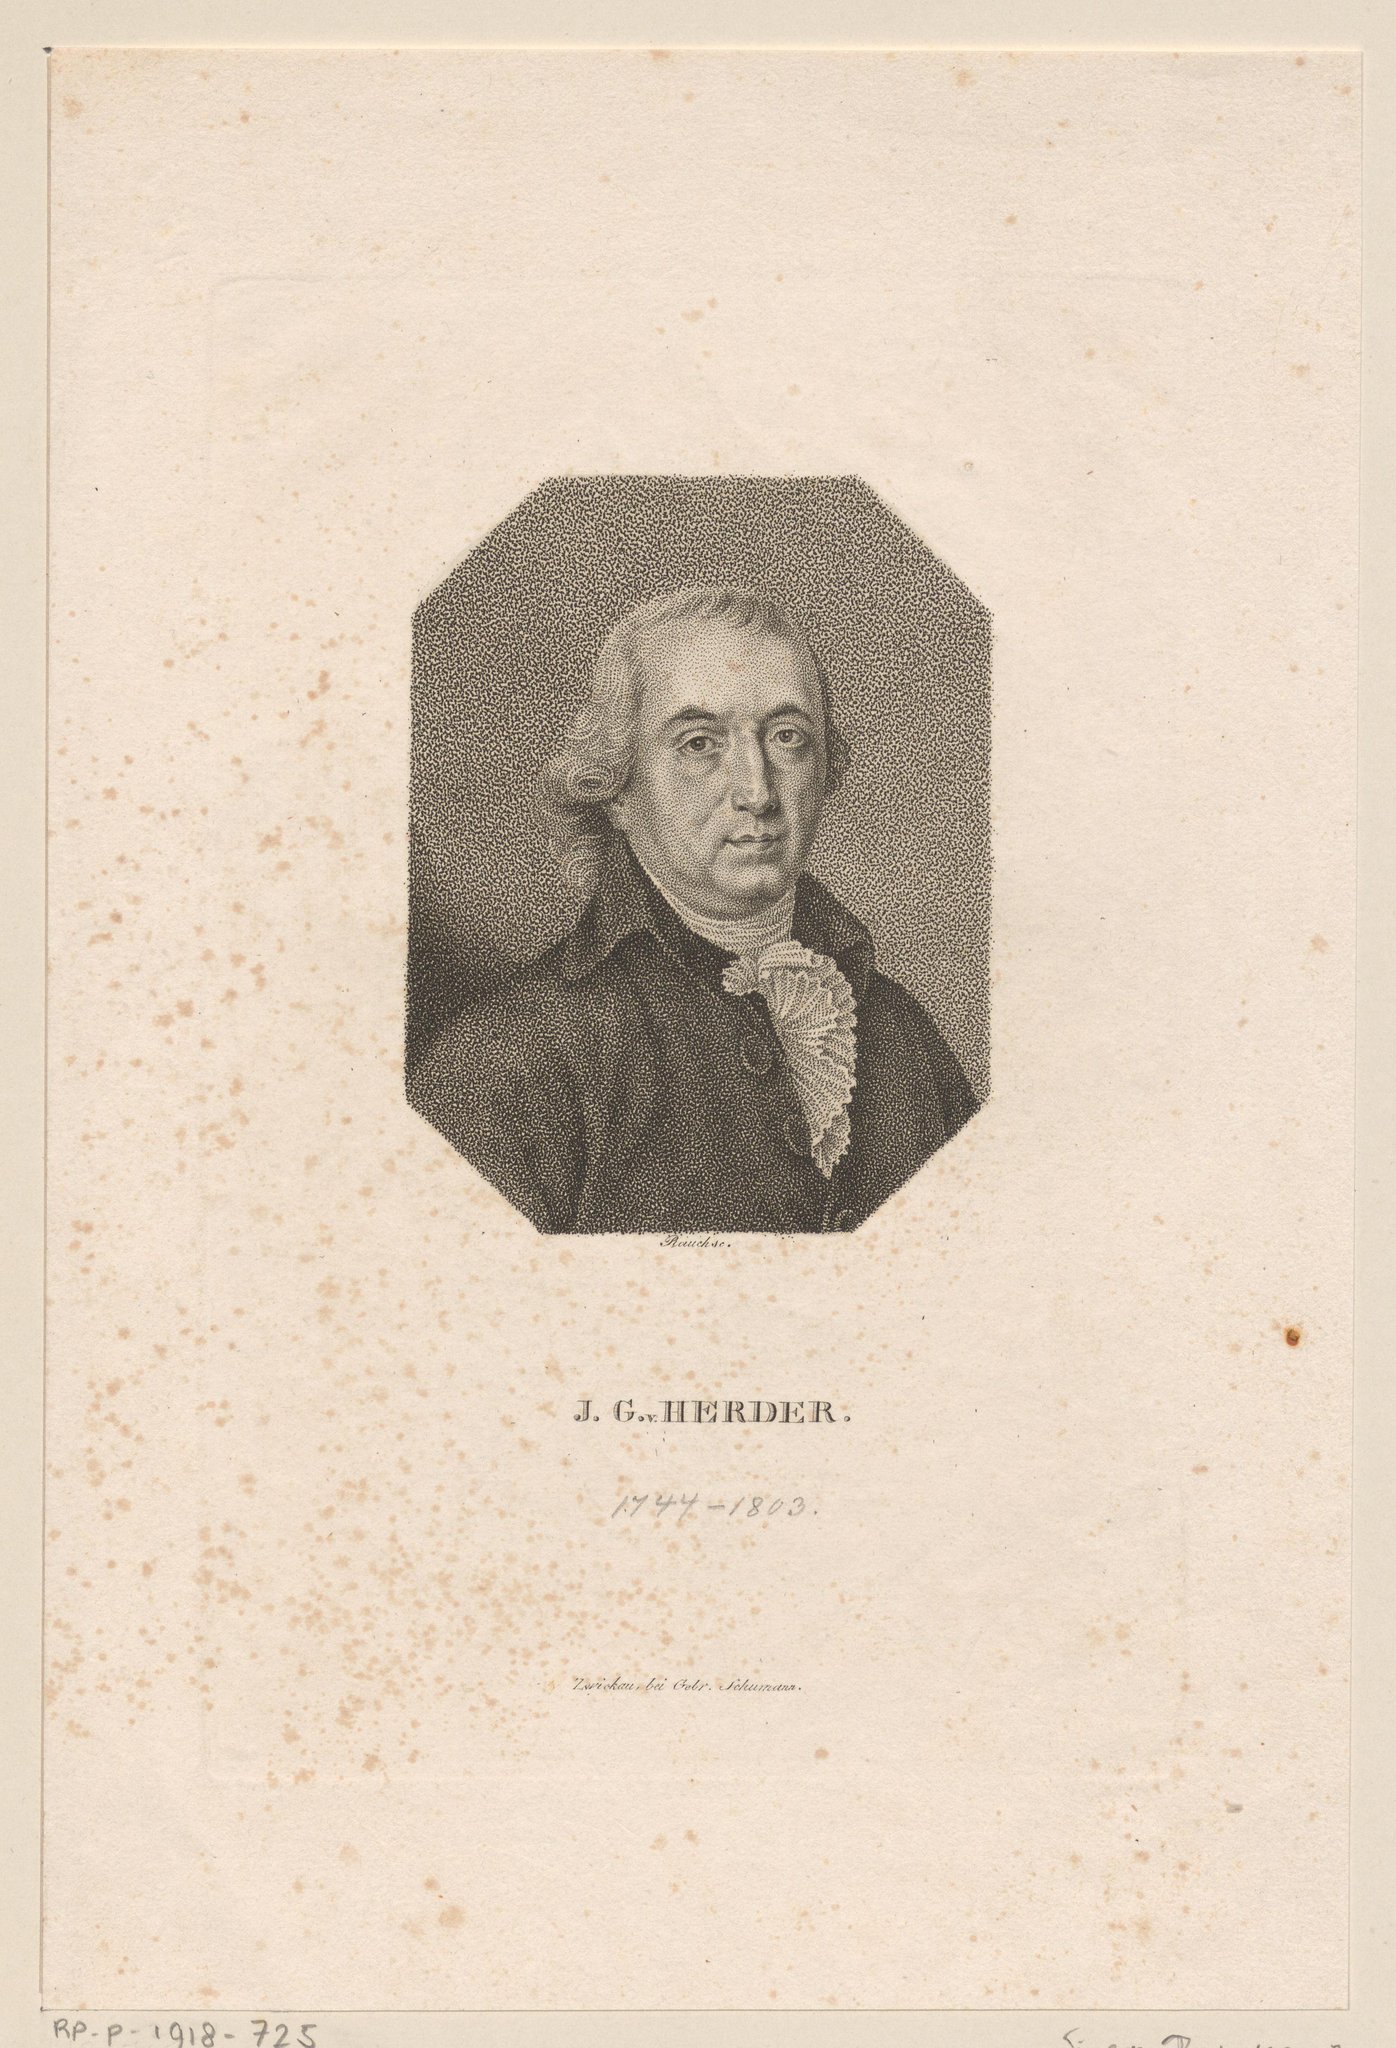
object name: print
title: Portret van Johann Gottfried von Herder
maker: ernst rauch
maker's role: print maker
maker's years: 1797-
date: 1832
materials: paper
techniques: engraving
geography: zwickau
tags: historical persons, writer, poet, author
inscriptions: collector's mark: Lugt 2228